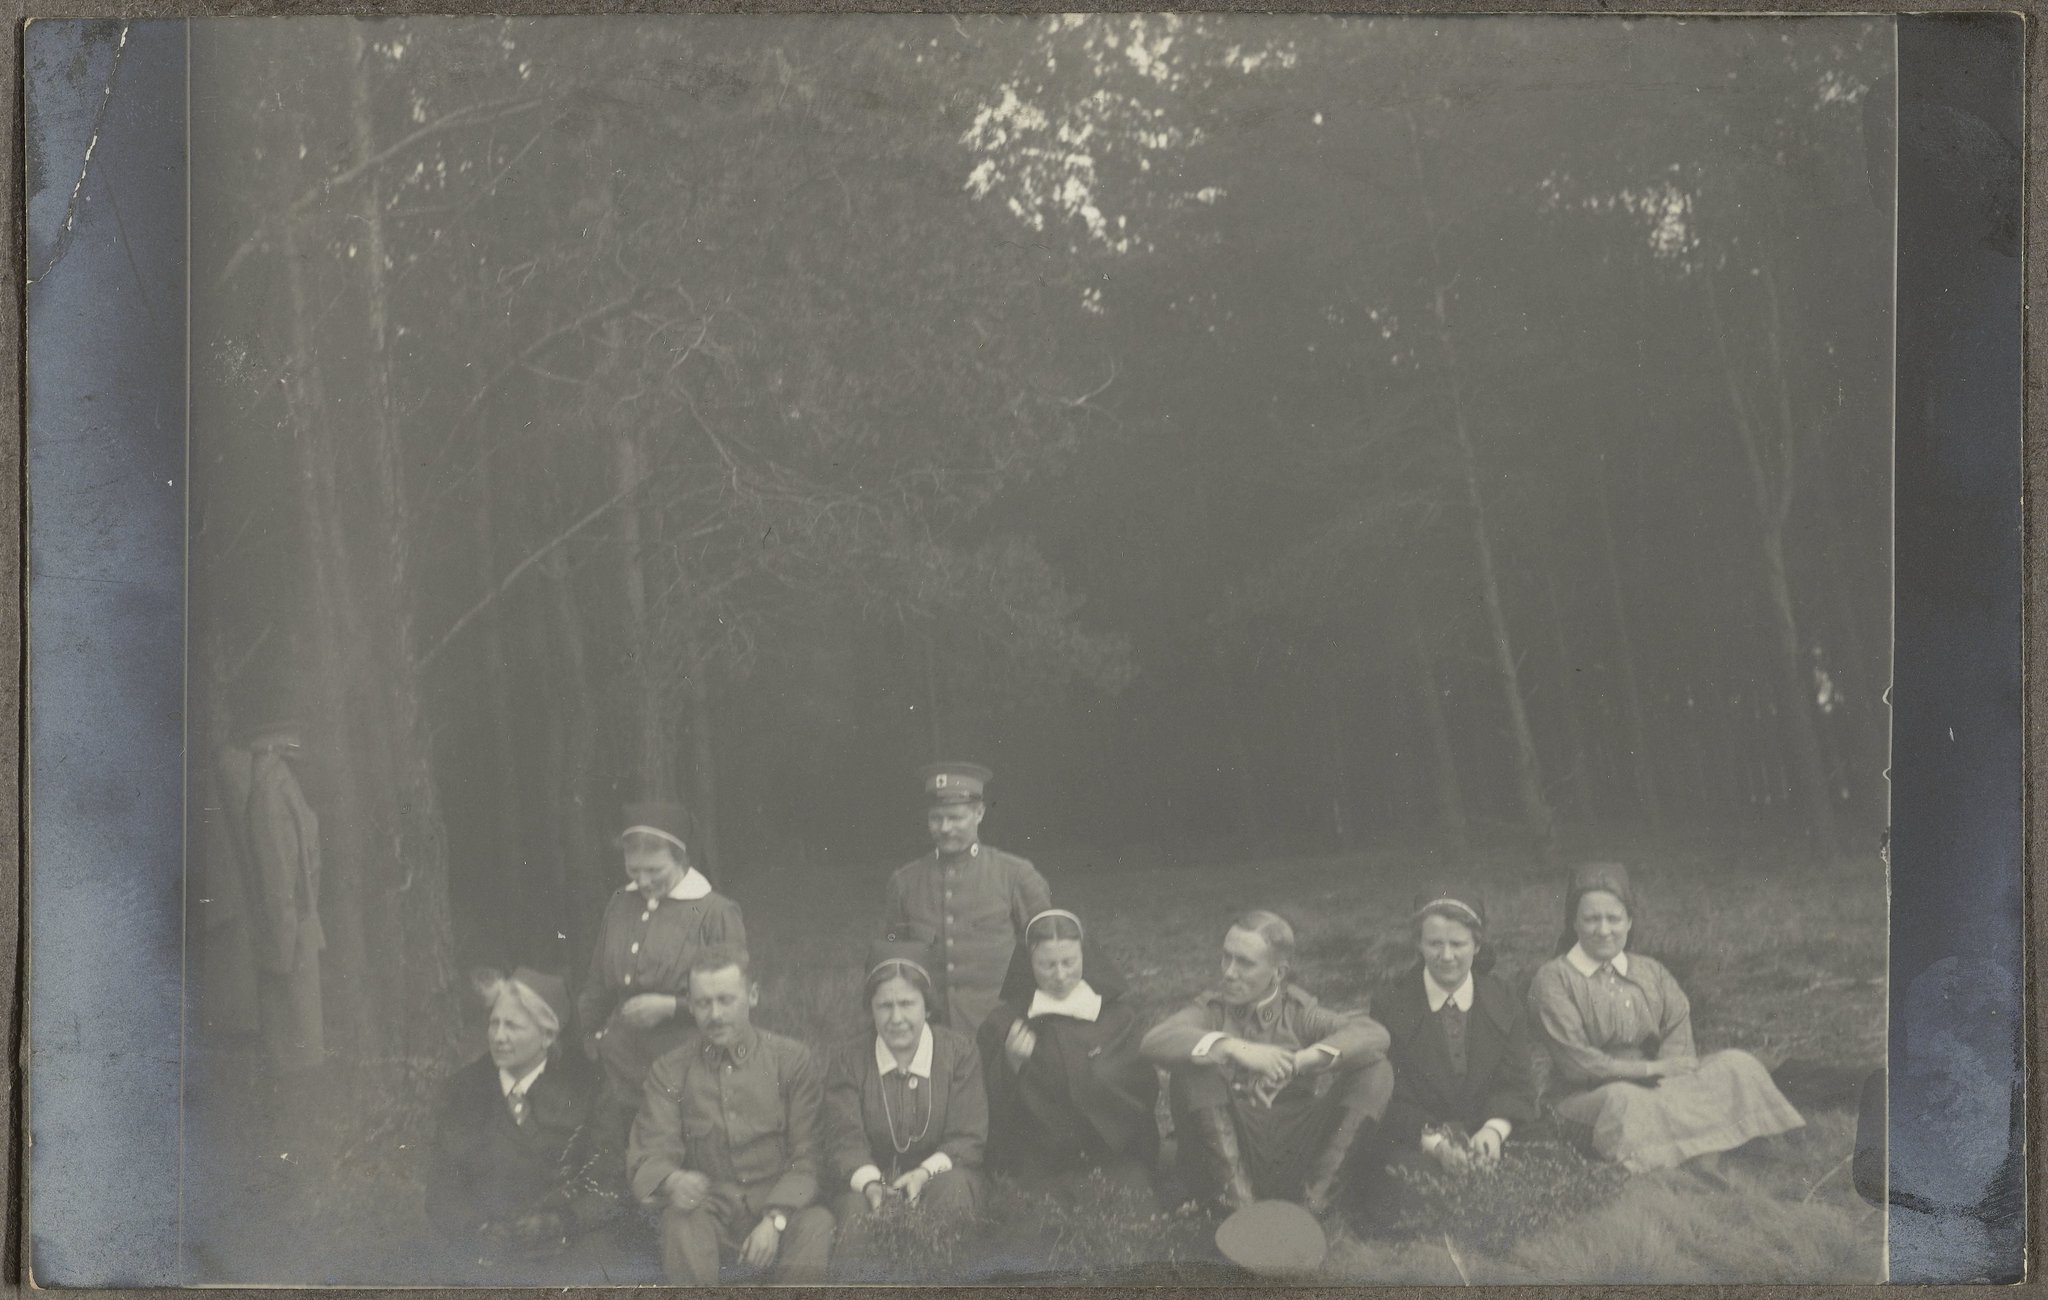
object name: photograph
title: Groepsportret van verpleegsters en mannen in uniform in het bos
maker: Anonymous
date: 1912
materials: photographic support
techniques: gelatin silver print